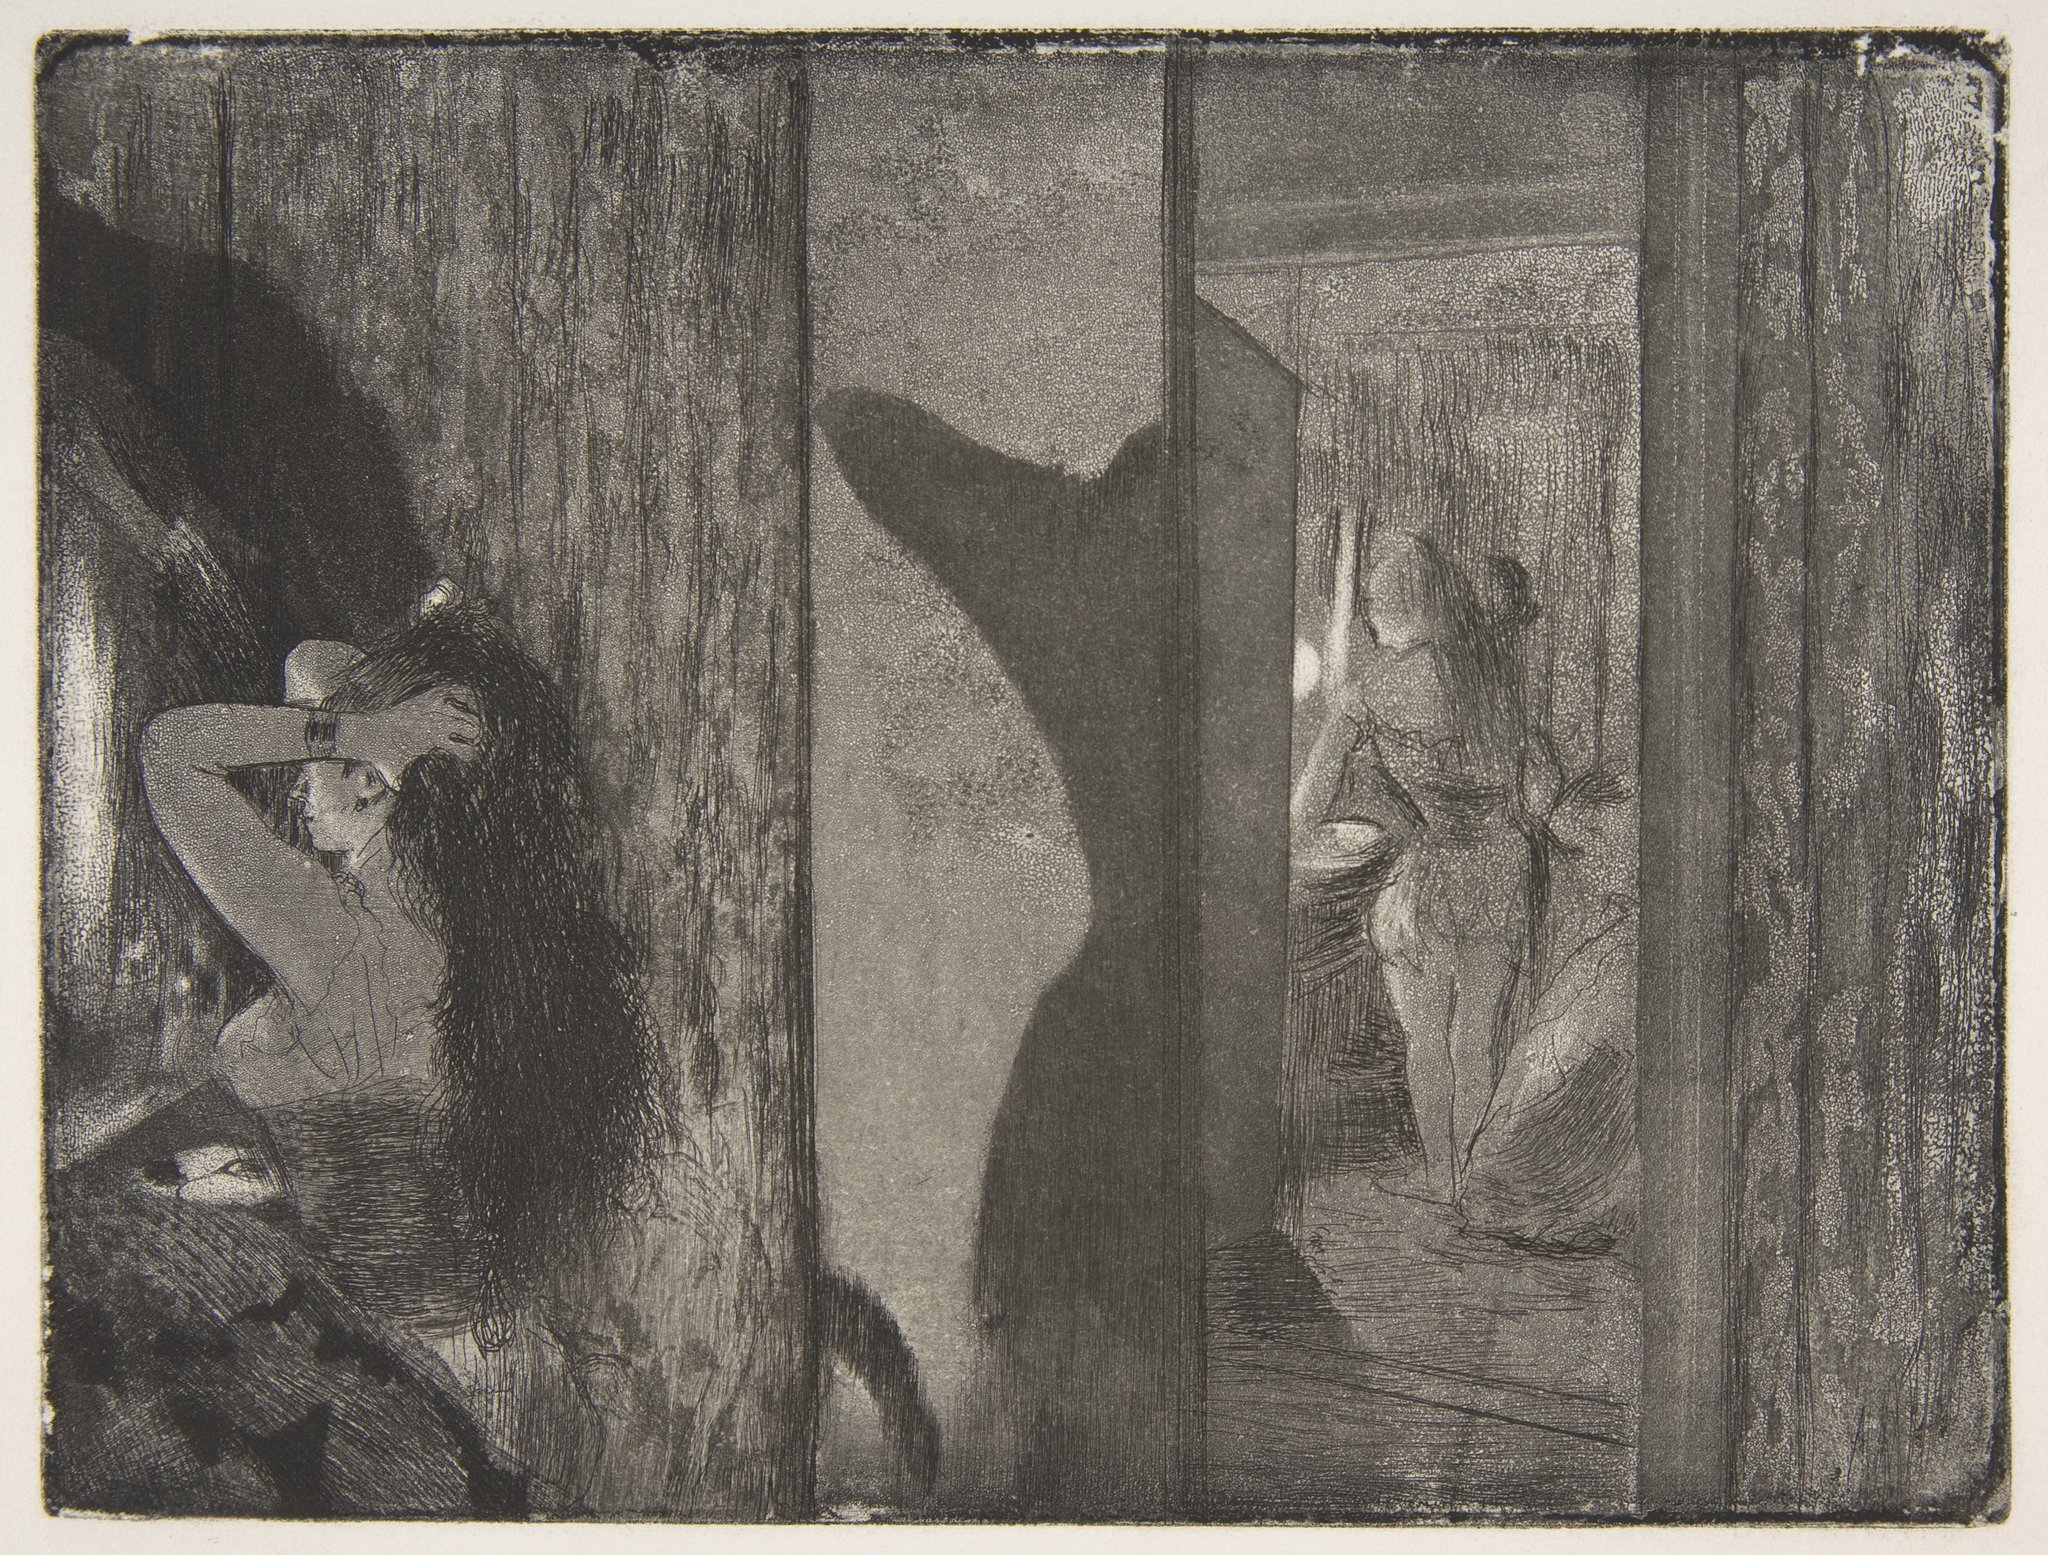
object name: print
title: Actresses in Their Dressing Rooms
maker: edgar degas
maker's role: artist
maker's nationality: french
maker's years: 1834-1917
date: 1879-1880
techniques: aquatint, etching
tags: women,actresses